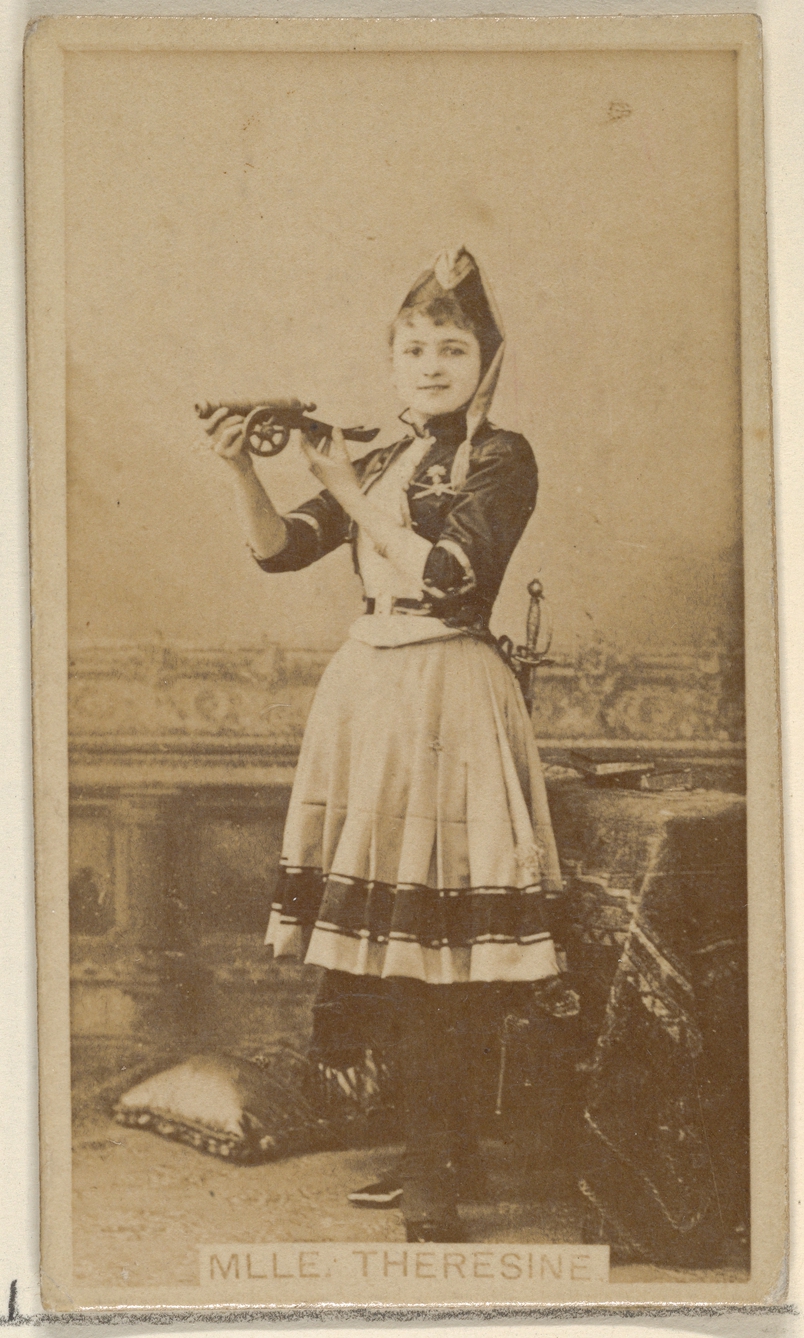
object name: photograph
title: Mlle. Theresine, from the Actors and Actresses series (N45, Type 8) for Virginia Brights Cigarettes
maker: allen & ginter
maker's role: publisher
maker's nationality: american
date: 1888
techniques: albumen silver print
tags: portraits,women,actresses